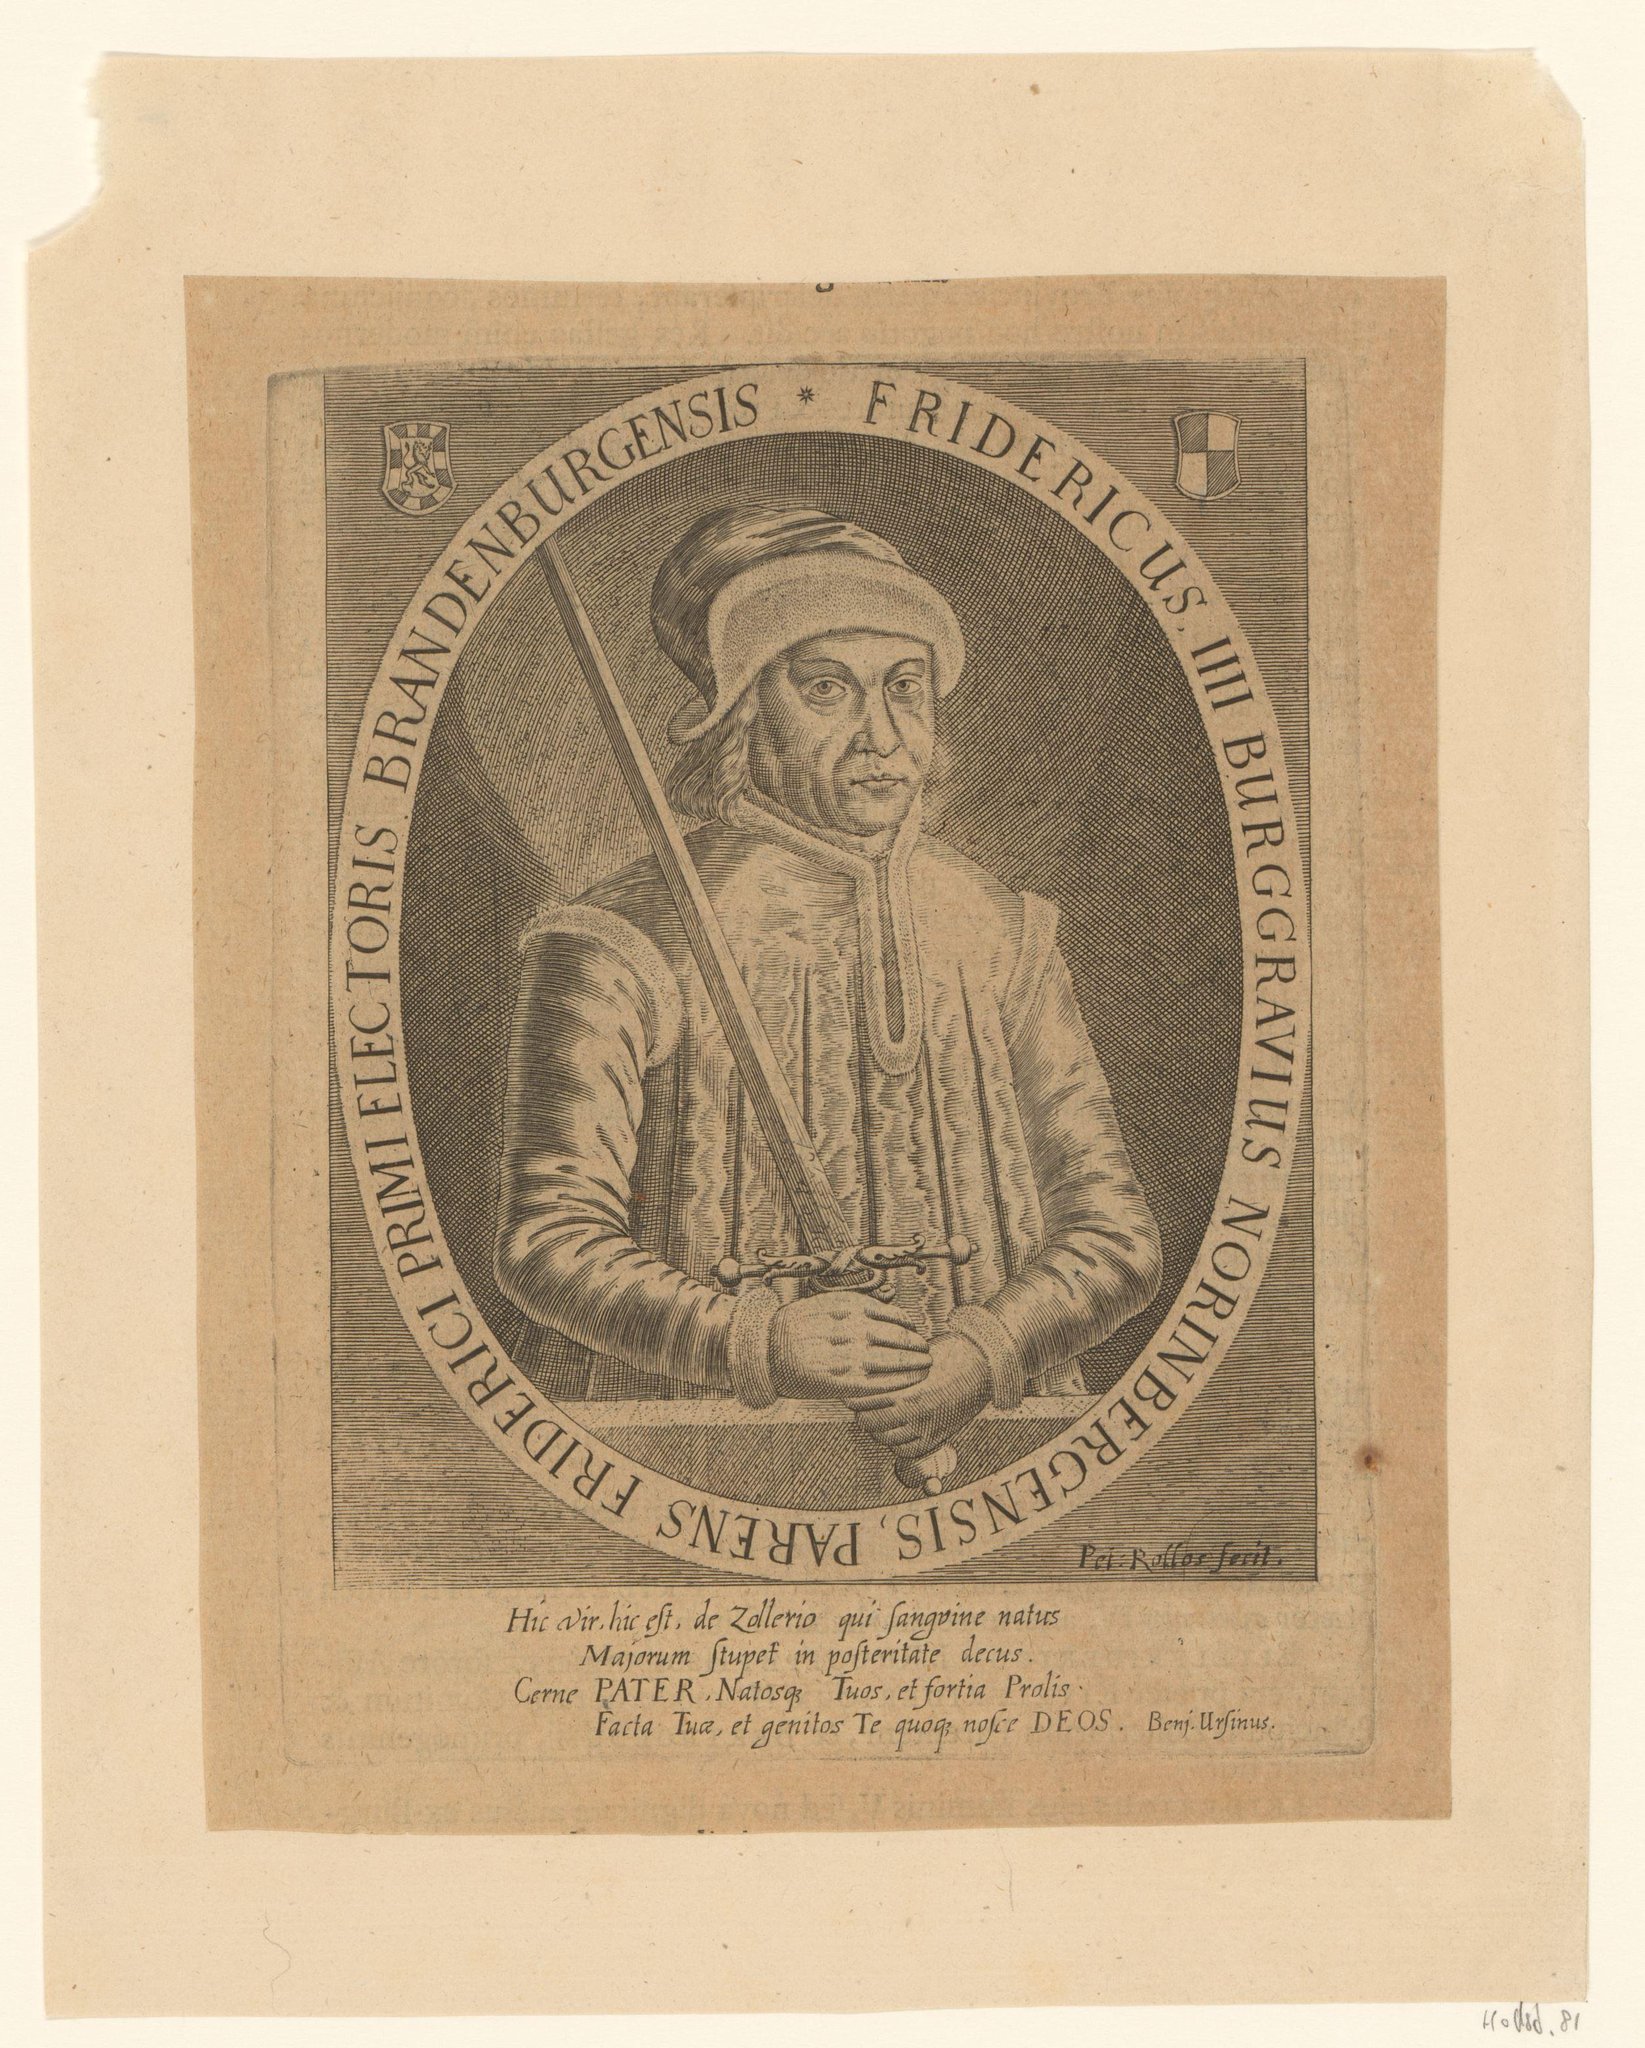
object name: print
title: Portret van Frederik IV van Neurenberg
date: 1625-1626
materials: paper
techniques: engraving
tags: historical persons, hacking and thrusting weapons: sword, armorial bearing, heraldry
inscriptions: collector's mark: Lugt 2228, collector's mark: Lugt 1209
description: Prent ook gebruikt in: Kern, Johannes. Decem è Familiâ Burggraviorum (...). Berlijn: Georg Runge, 1626.